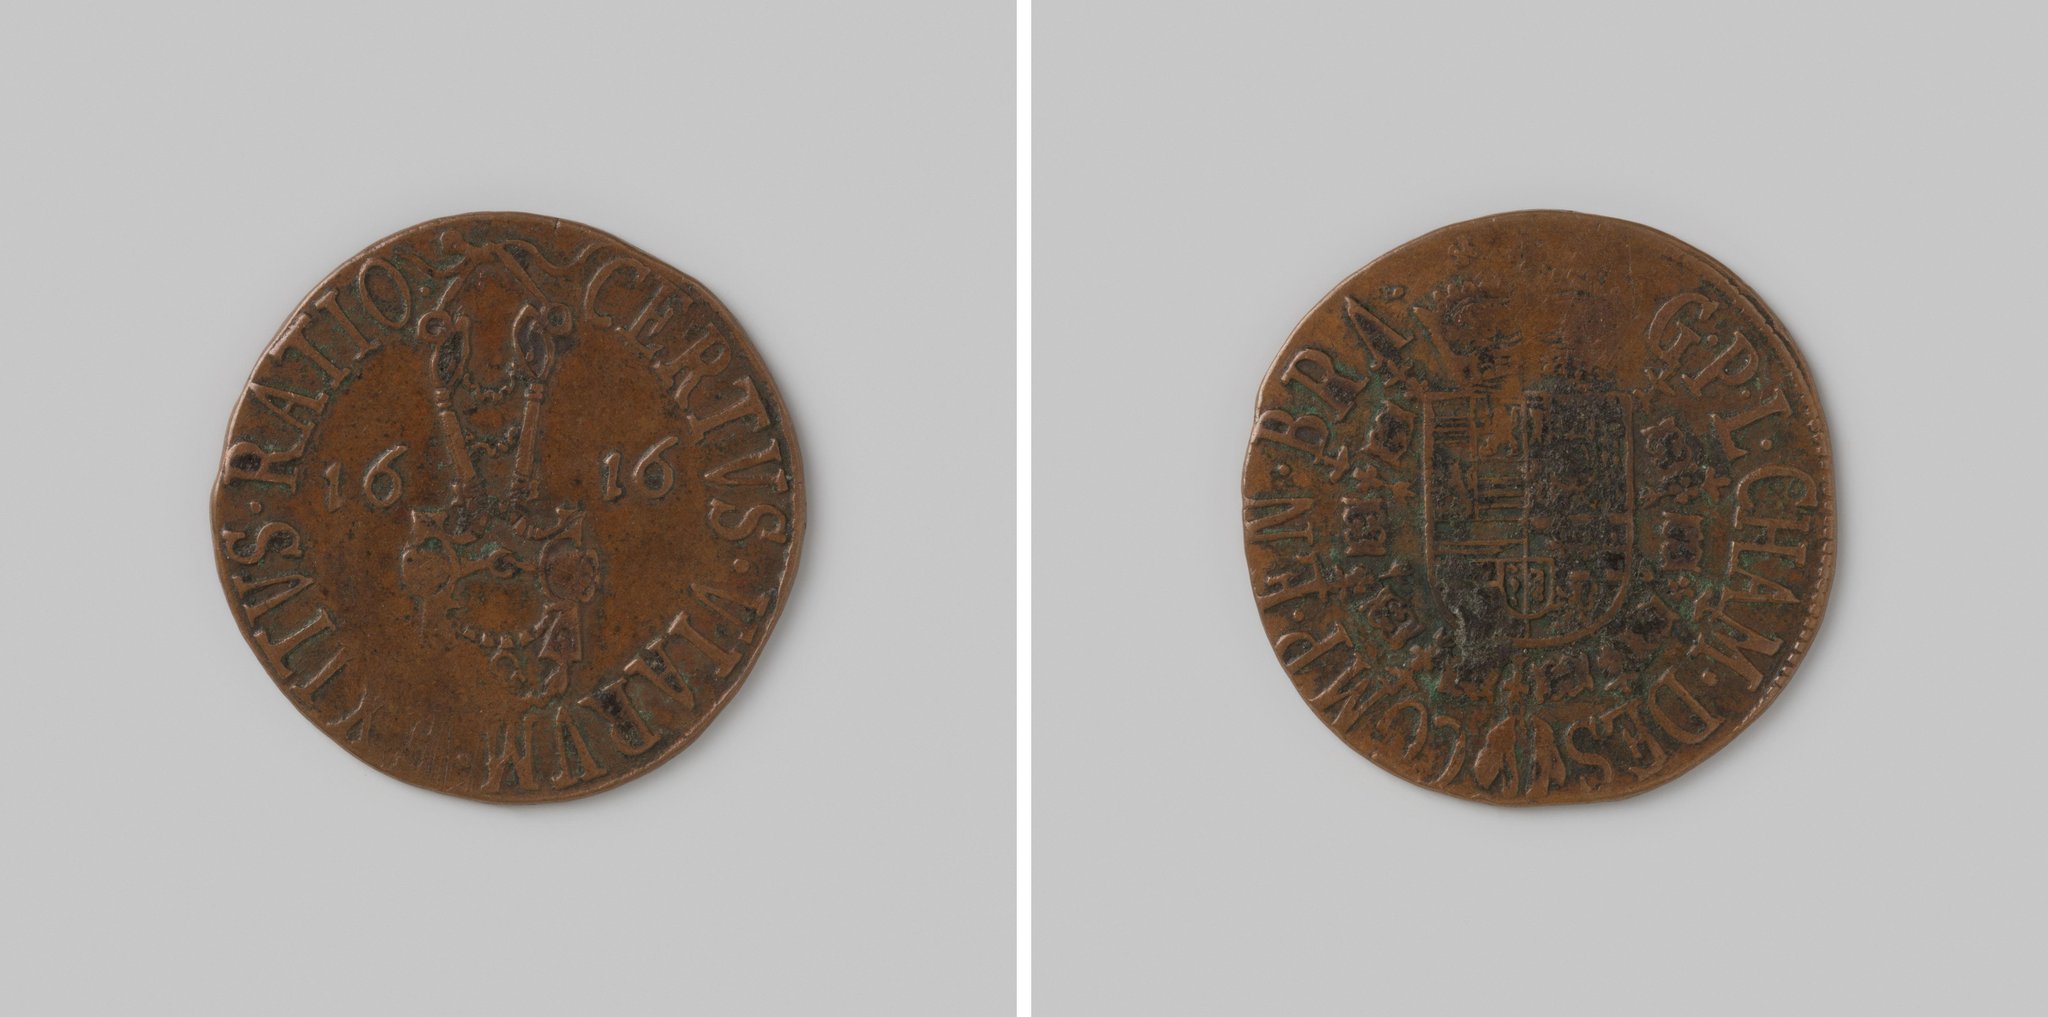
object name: history medal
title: Rekenpenning voor de Rekenkamer van Brabant op de veldtochten in Gulikerland 1616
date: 1616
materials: copper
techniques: striking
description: Koperen penning, op de voorzijde een paardenbit, met jaartal in het veld en omschrift, op de keerzijde het gekroonde Spaanse wapenschild omhangen met de keten van het Gulden Vlies, met omschrift.